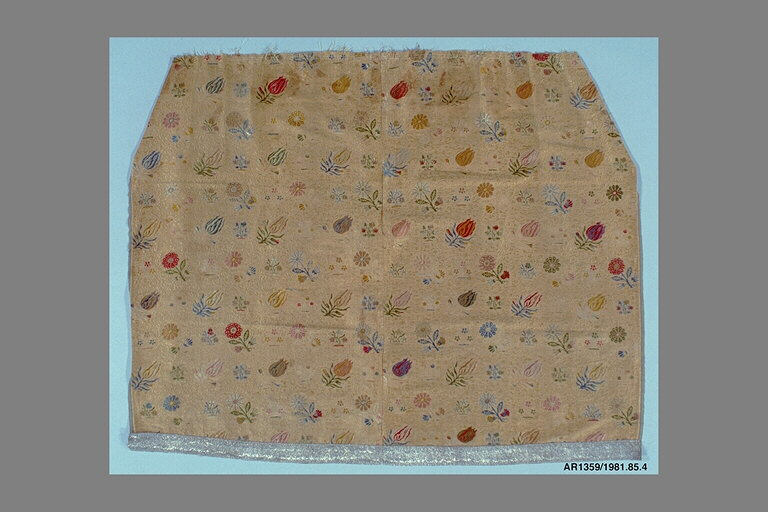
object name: piece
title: Woven silk skirt panel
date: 1634-1666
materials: metal thread, silk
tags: flowers